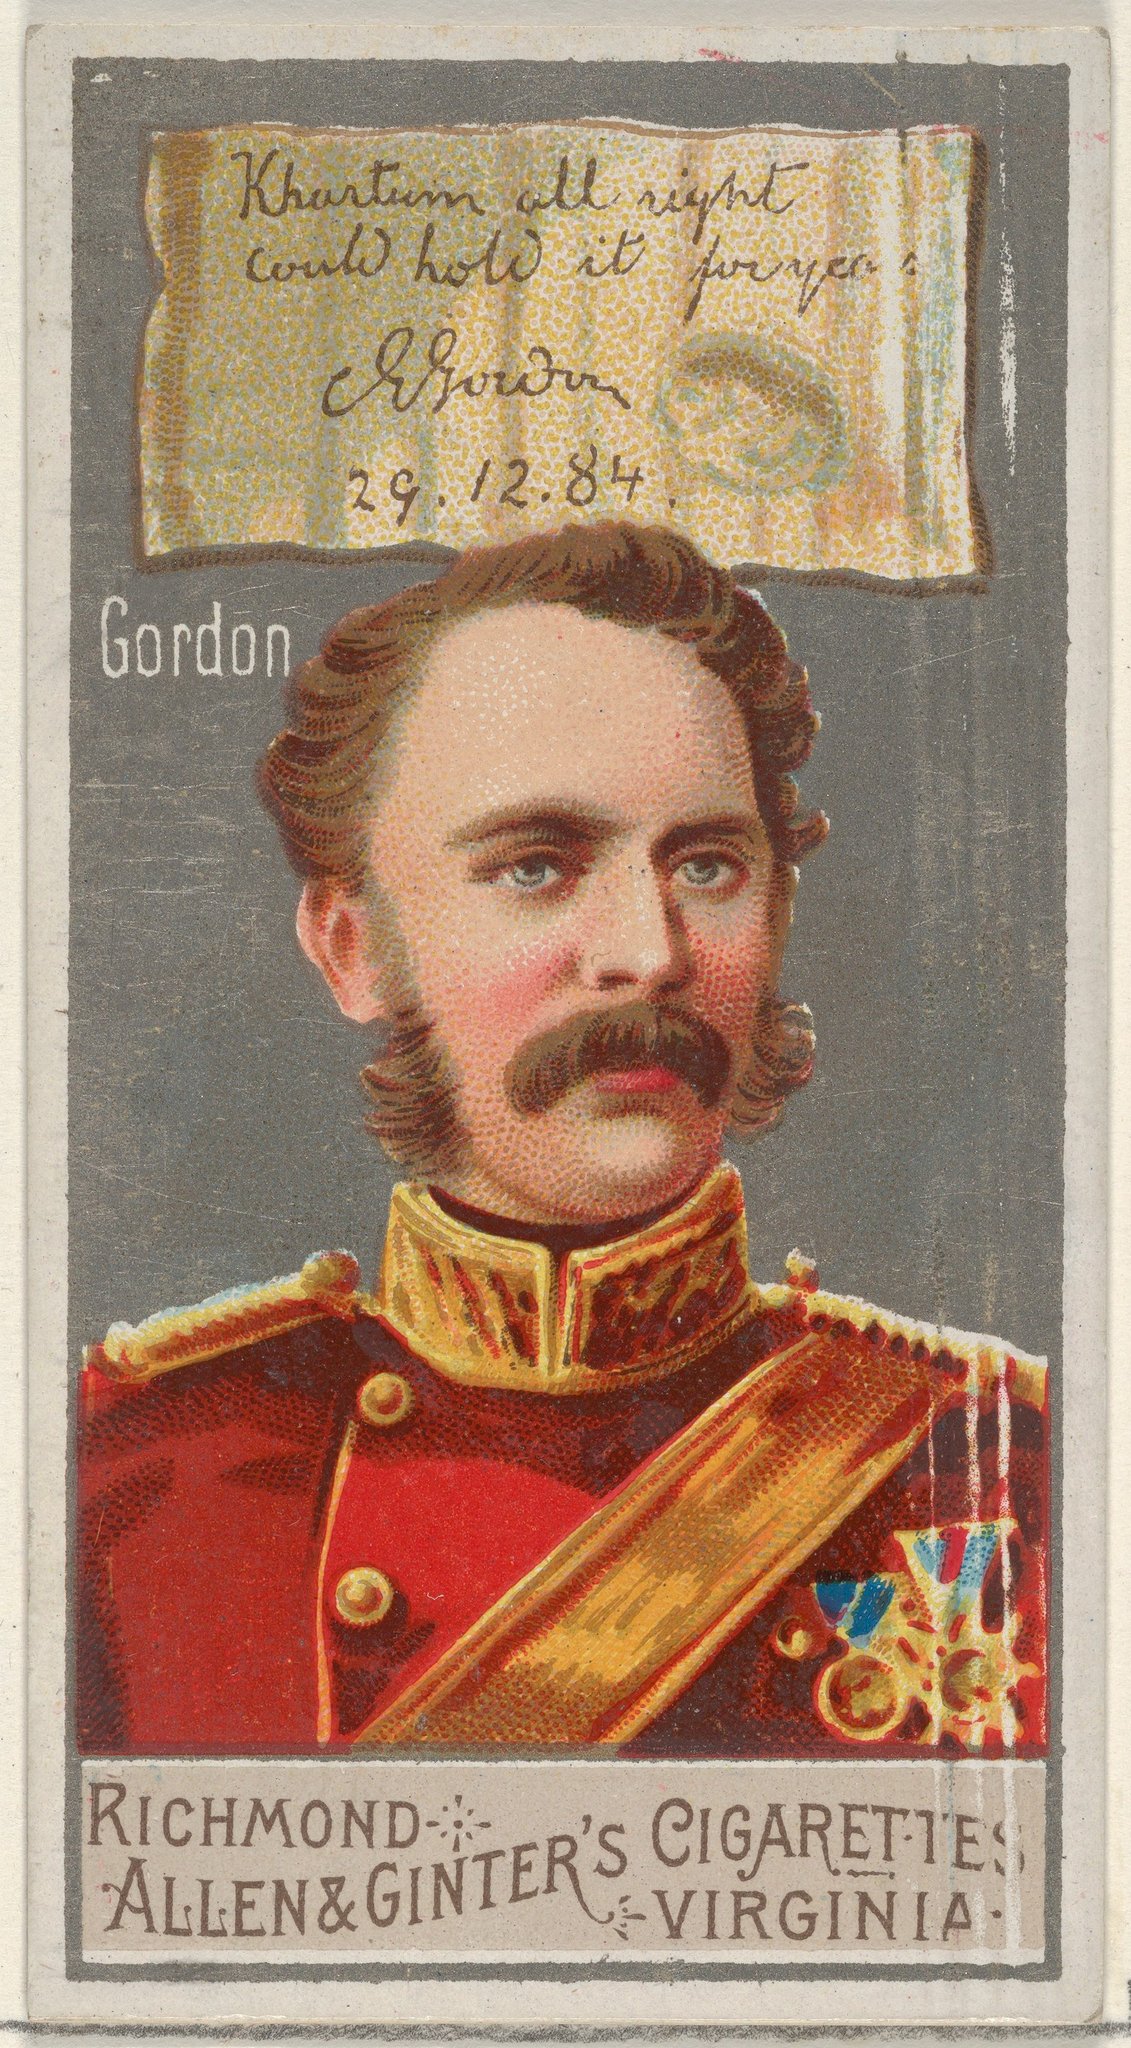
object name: print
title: Charles George Gordon, from the Great Generals series (N15) for Allen & Ginter Cigarettes Brands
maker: allen & ginter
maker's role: publisher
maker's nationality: american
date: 1888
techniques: color lithograph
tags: historical figures,men,generals